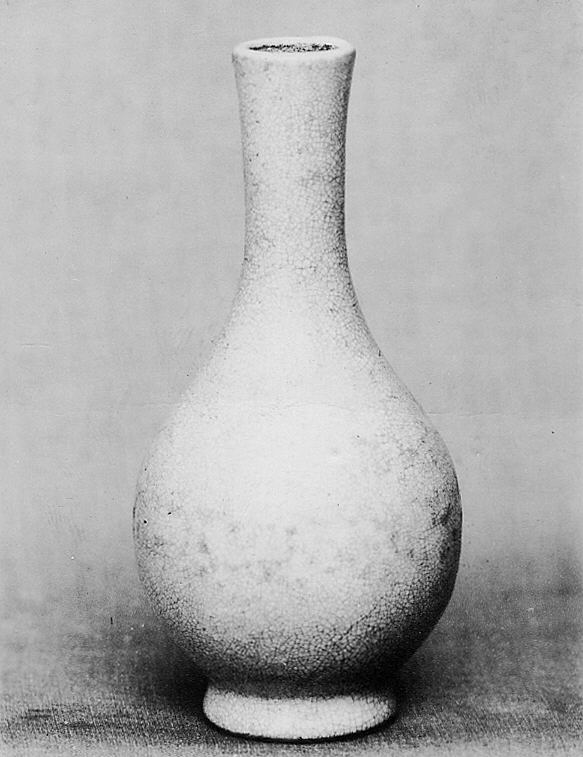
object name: snuff bottle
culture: chinese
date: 1736-1795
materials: porcelain